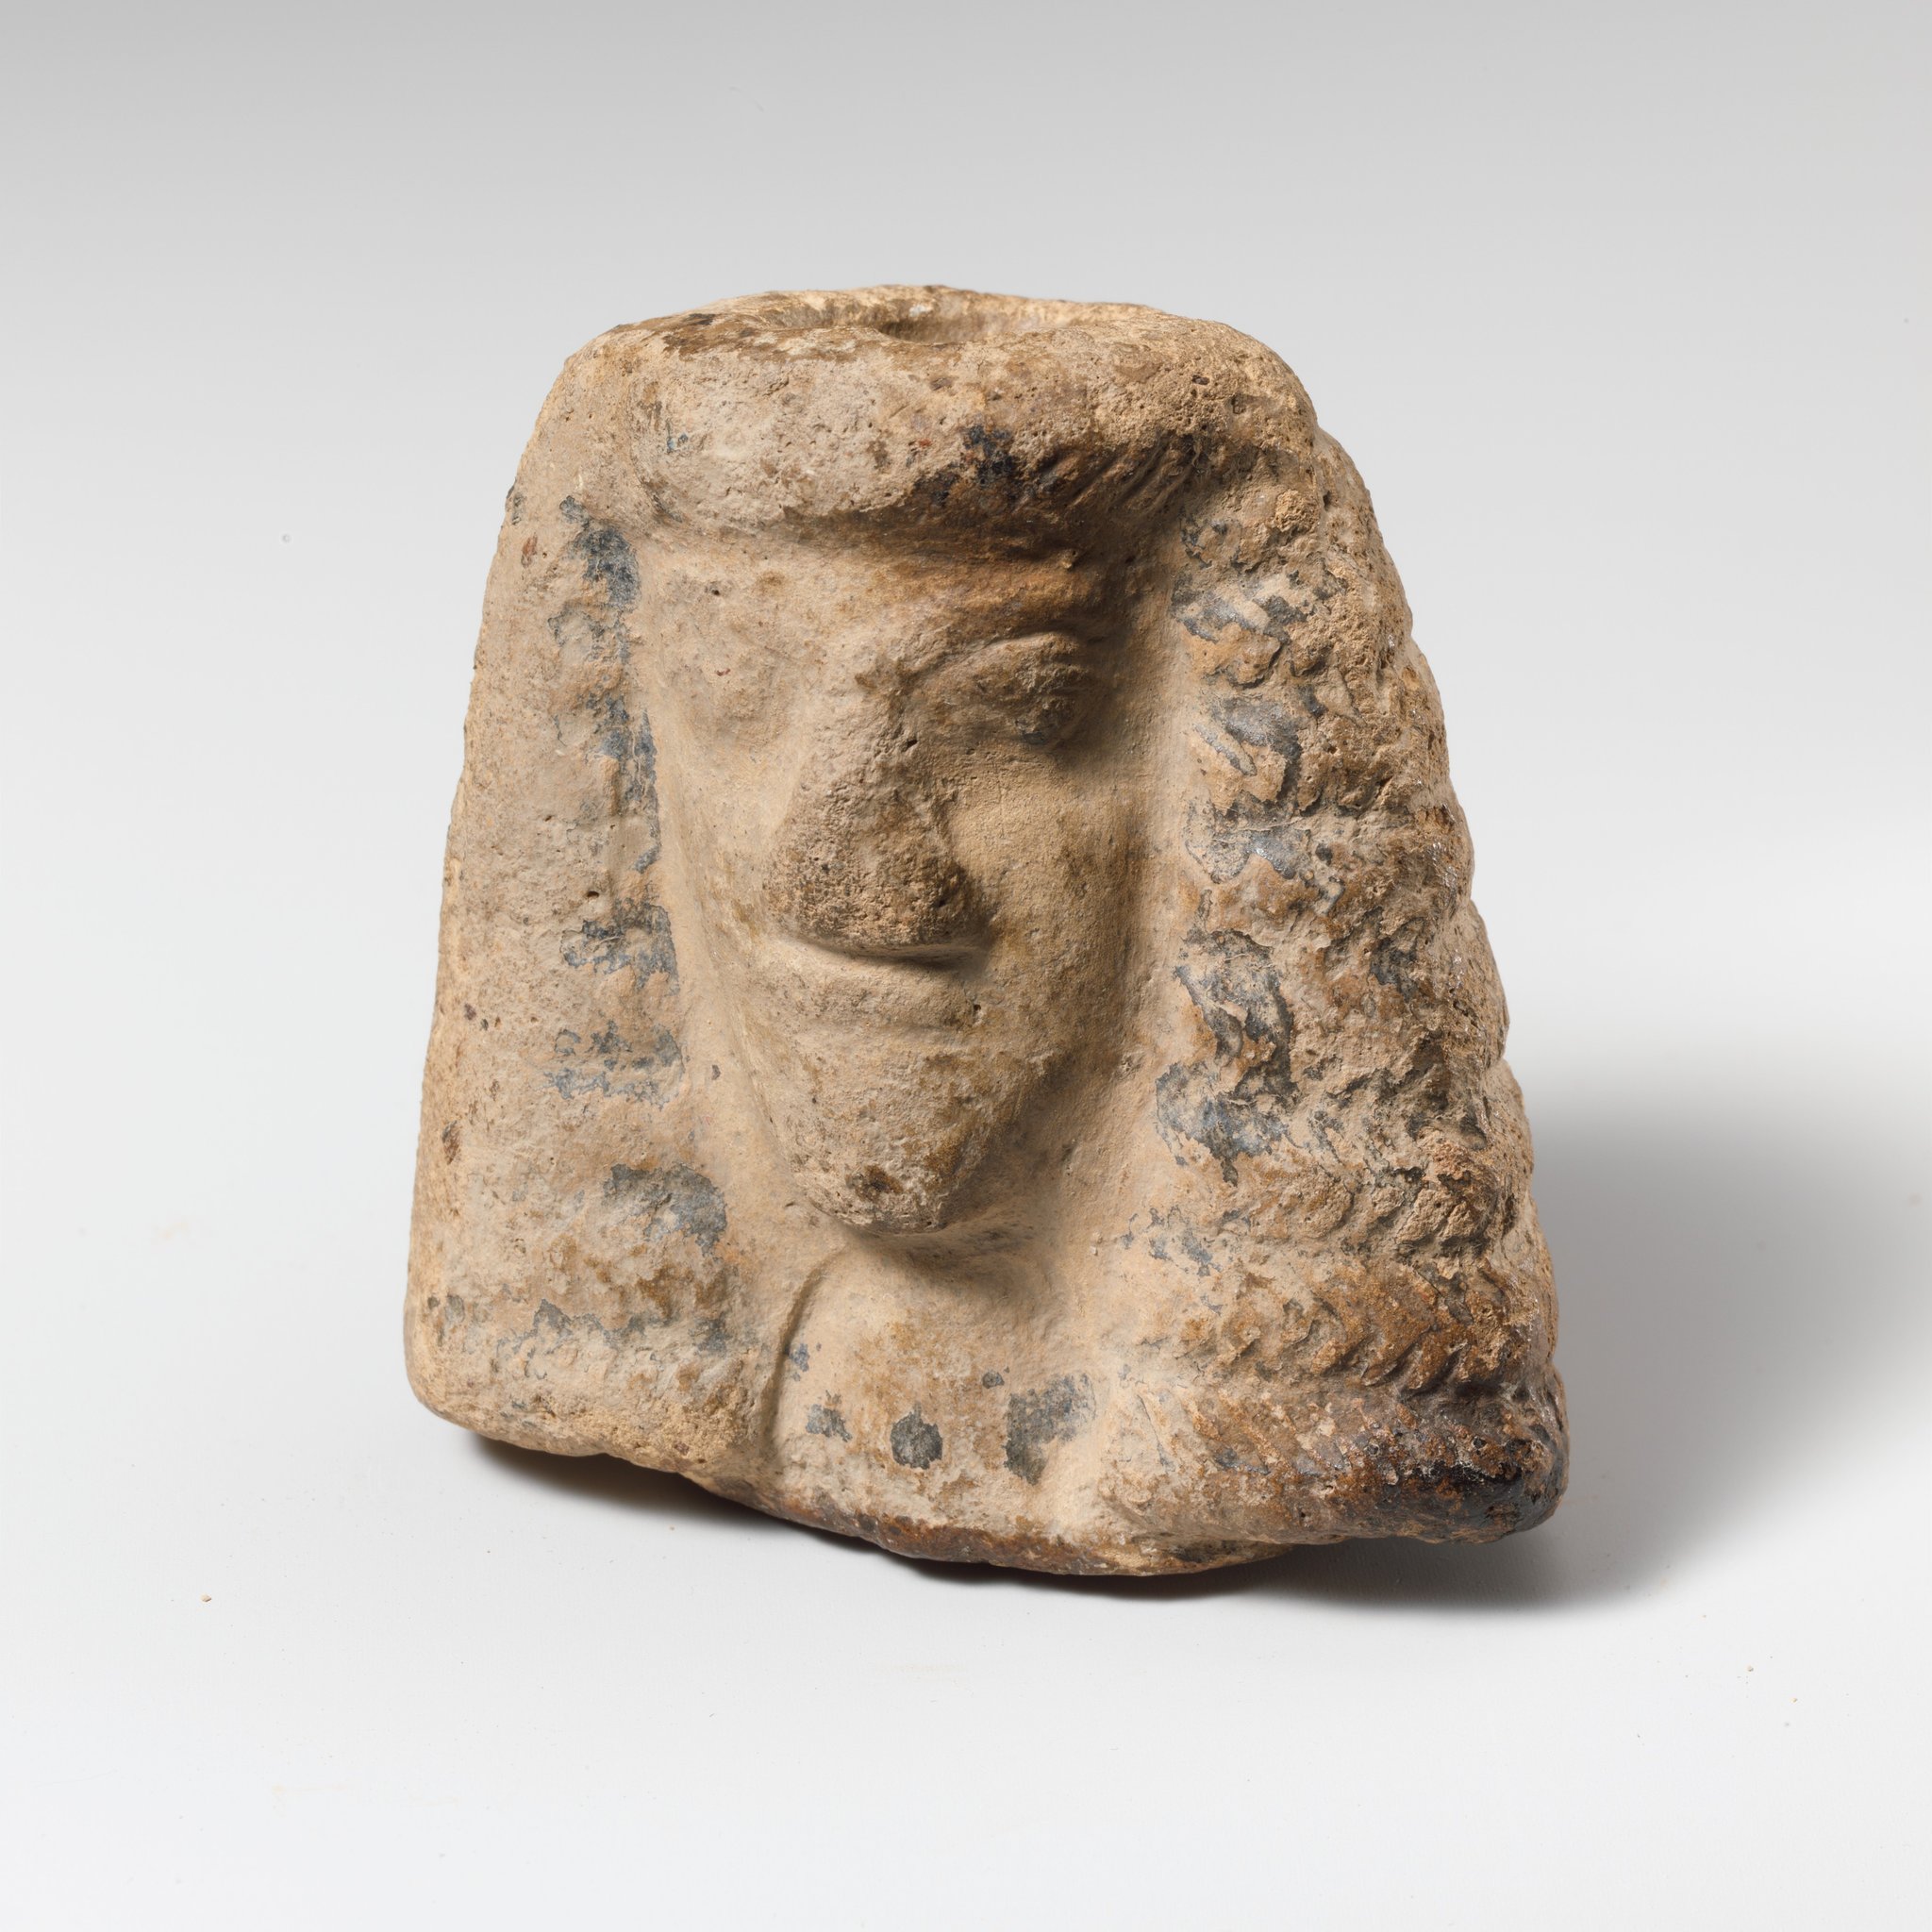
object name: head with hair in layer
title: Terracotta head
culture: greek, cretan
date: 700-601 BCE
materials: terracotta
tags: heads